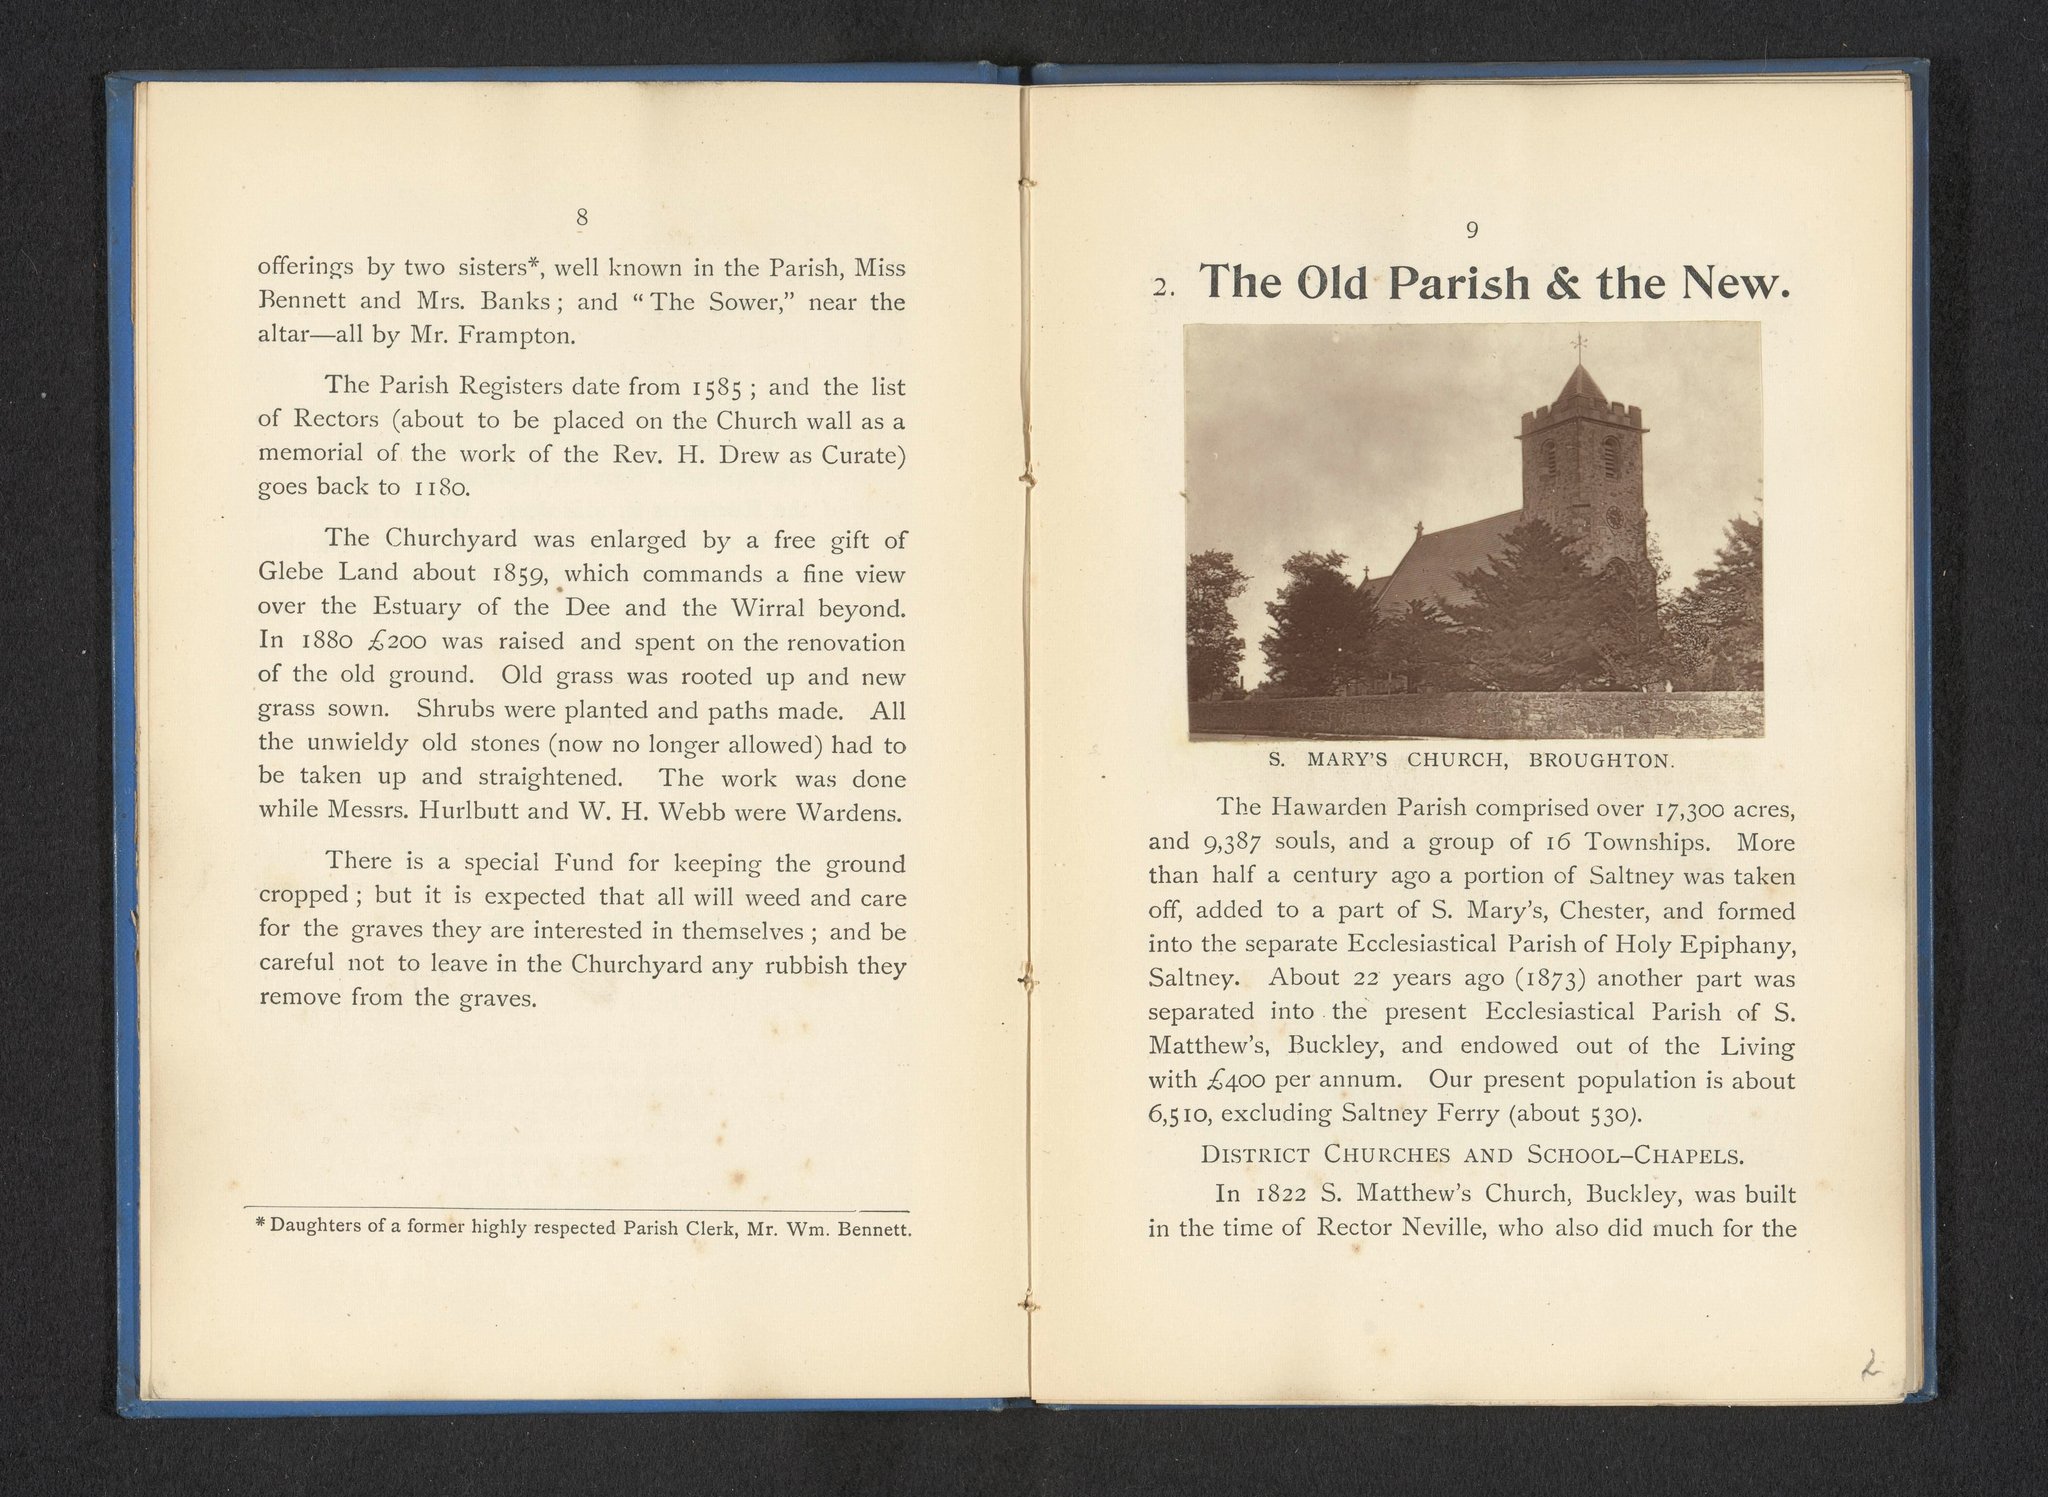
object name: photomechanical print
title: S. Mary's Church, Broughton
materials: paper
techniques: woodburytype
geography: broughton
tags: church (exterior), façade (of house or building)